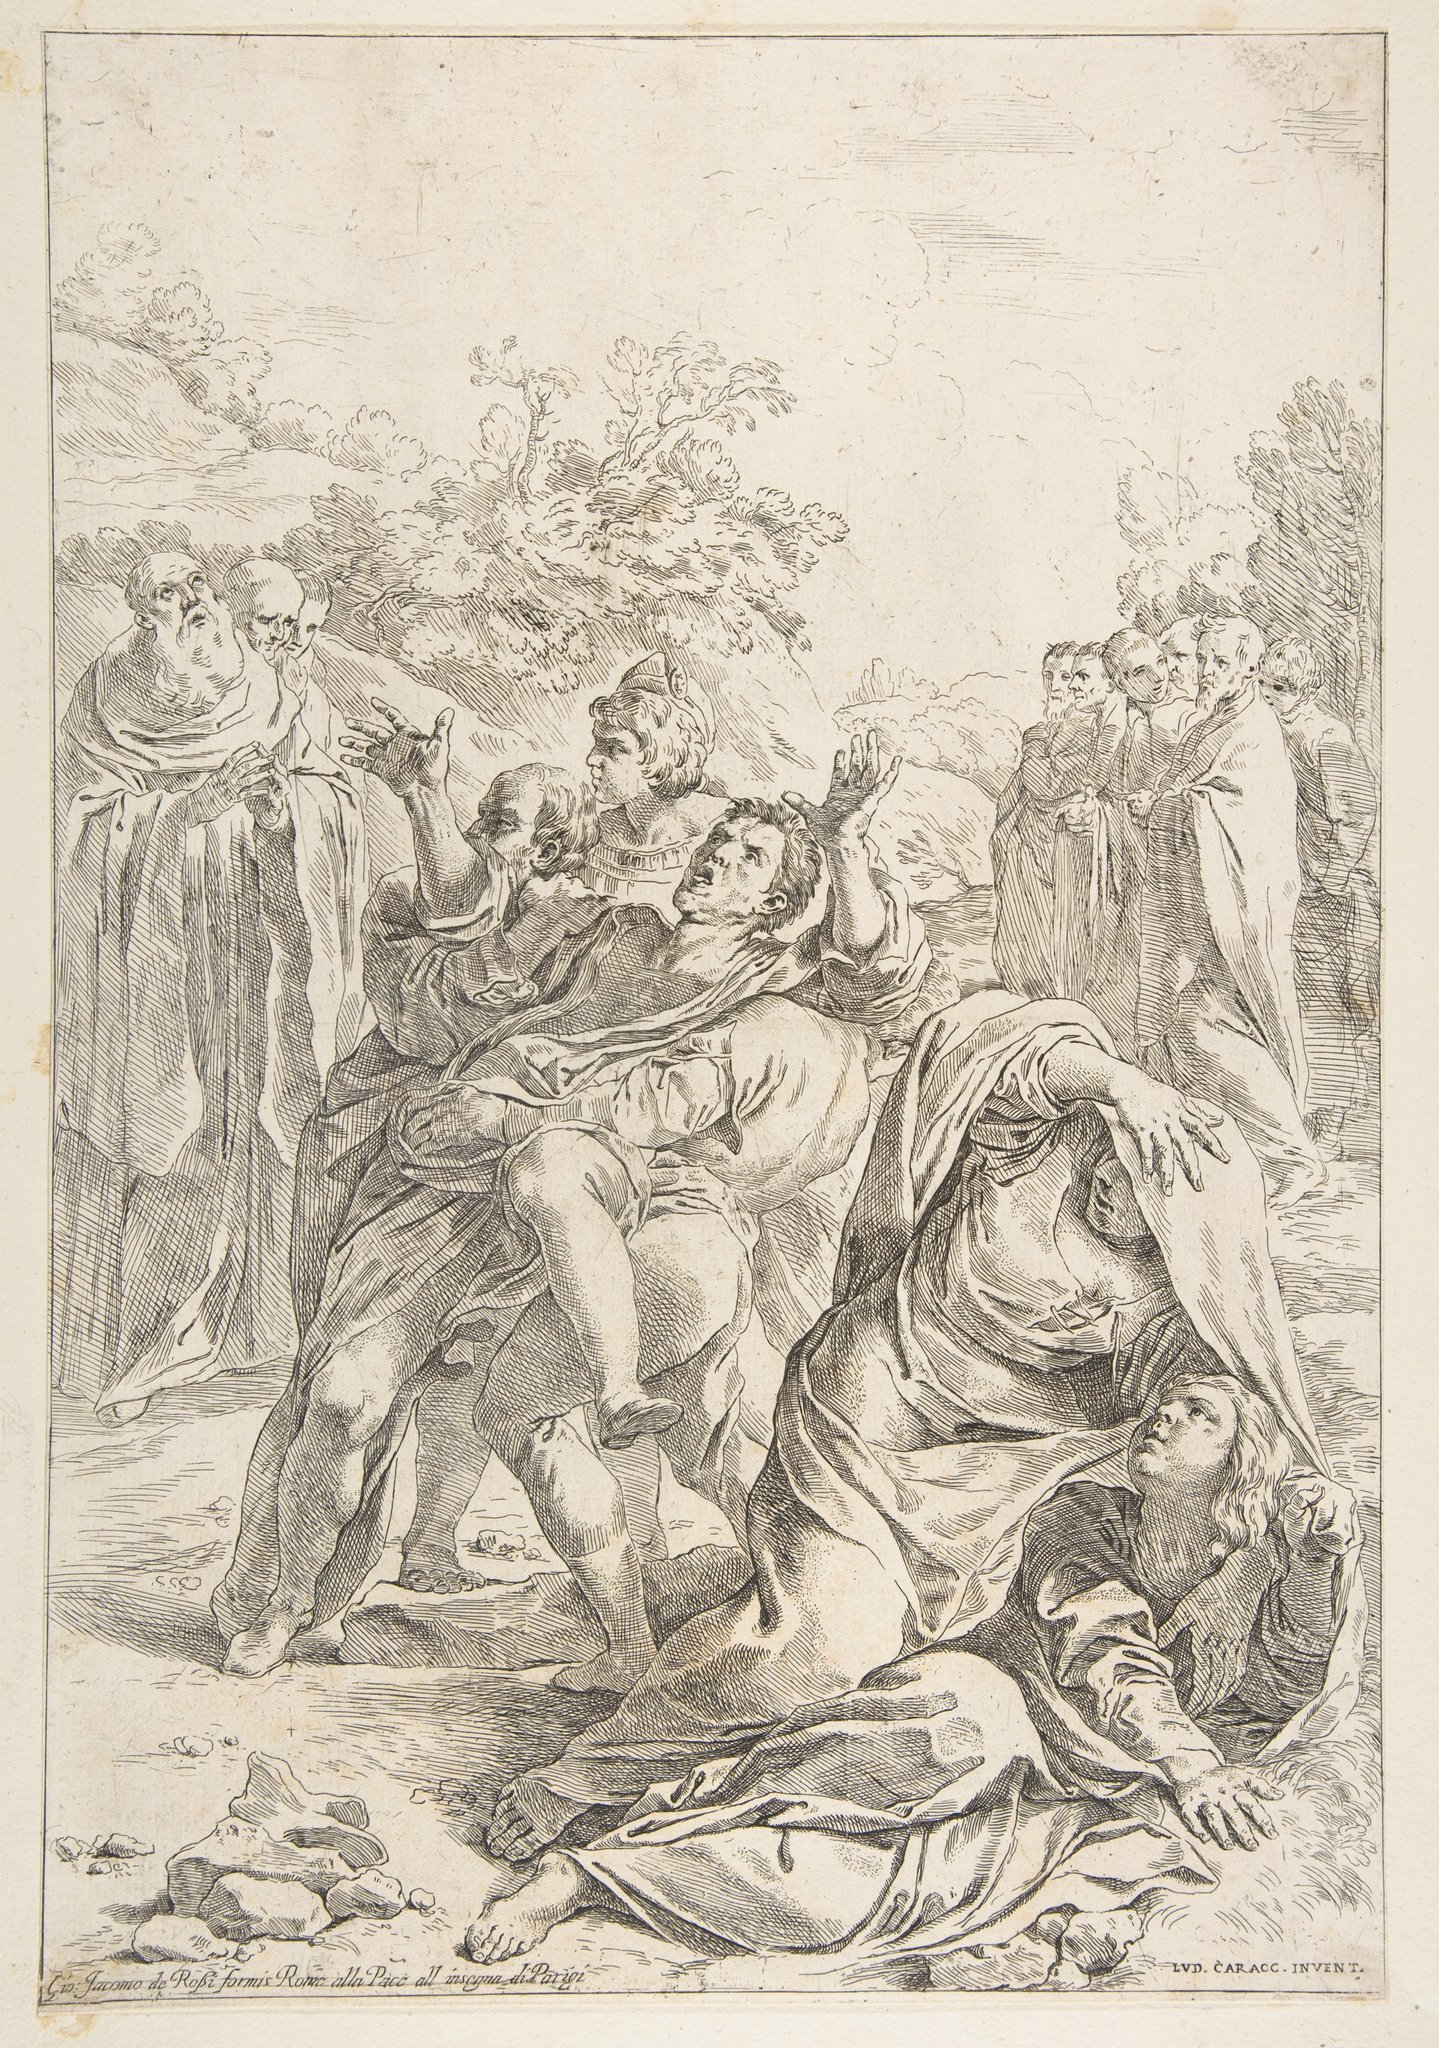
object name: print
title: Saint Benedict exorcising a demon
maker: simone cantarini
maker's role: artist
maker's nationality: italian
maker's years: 1612-1648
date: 1637-1639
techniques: etching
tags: men,women,saints